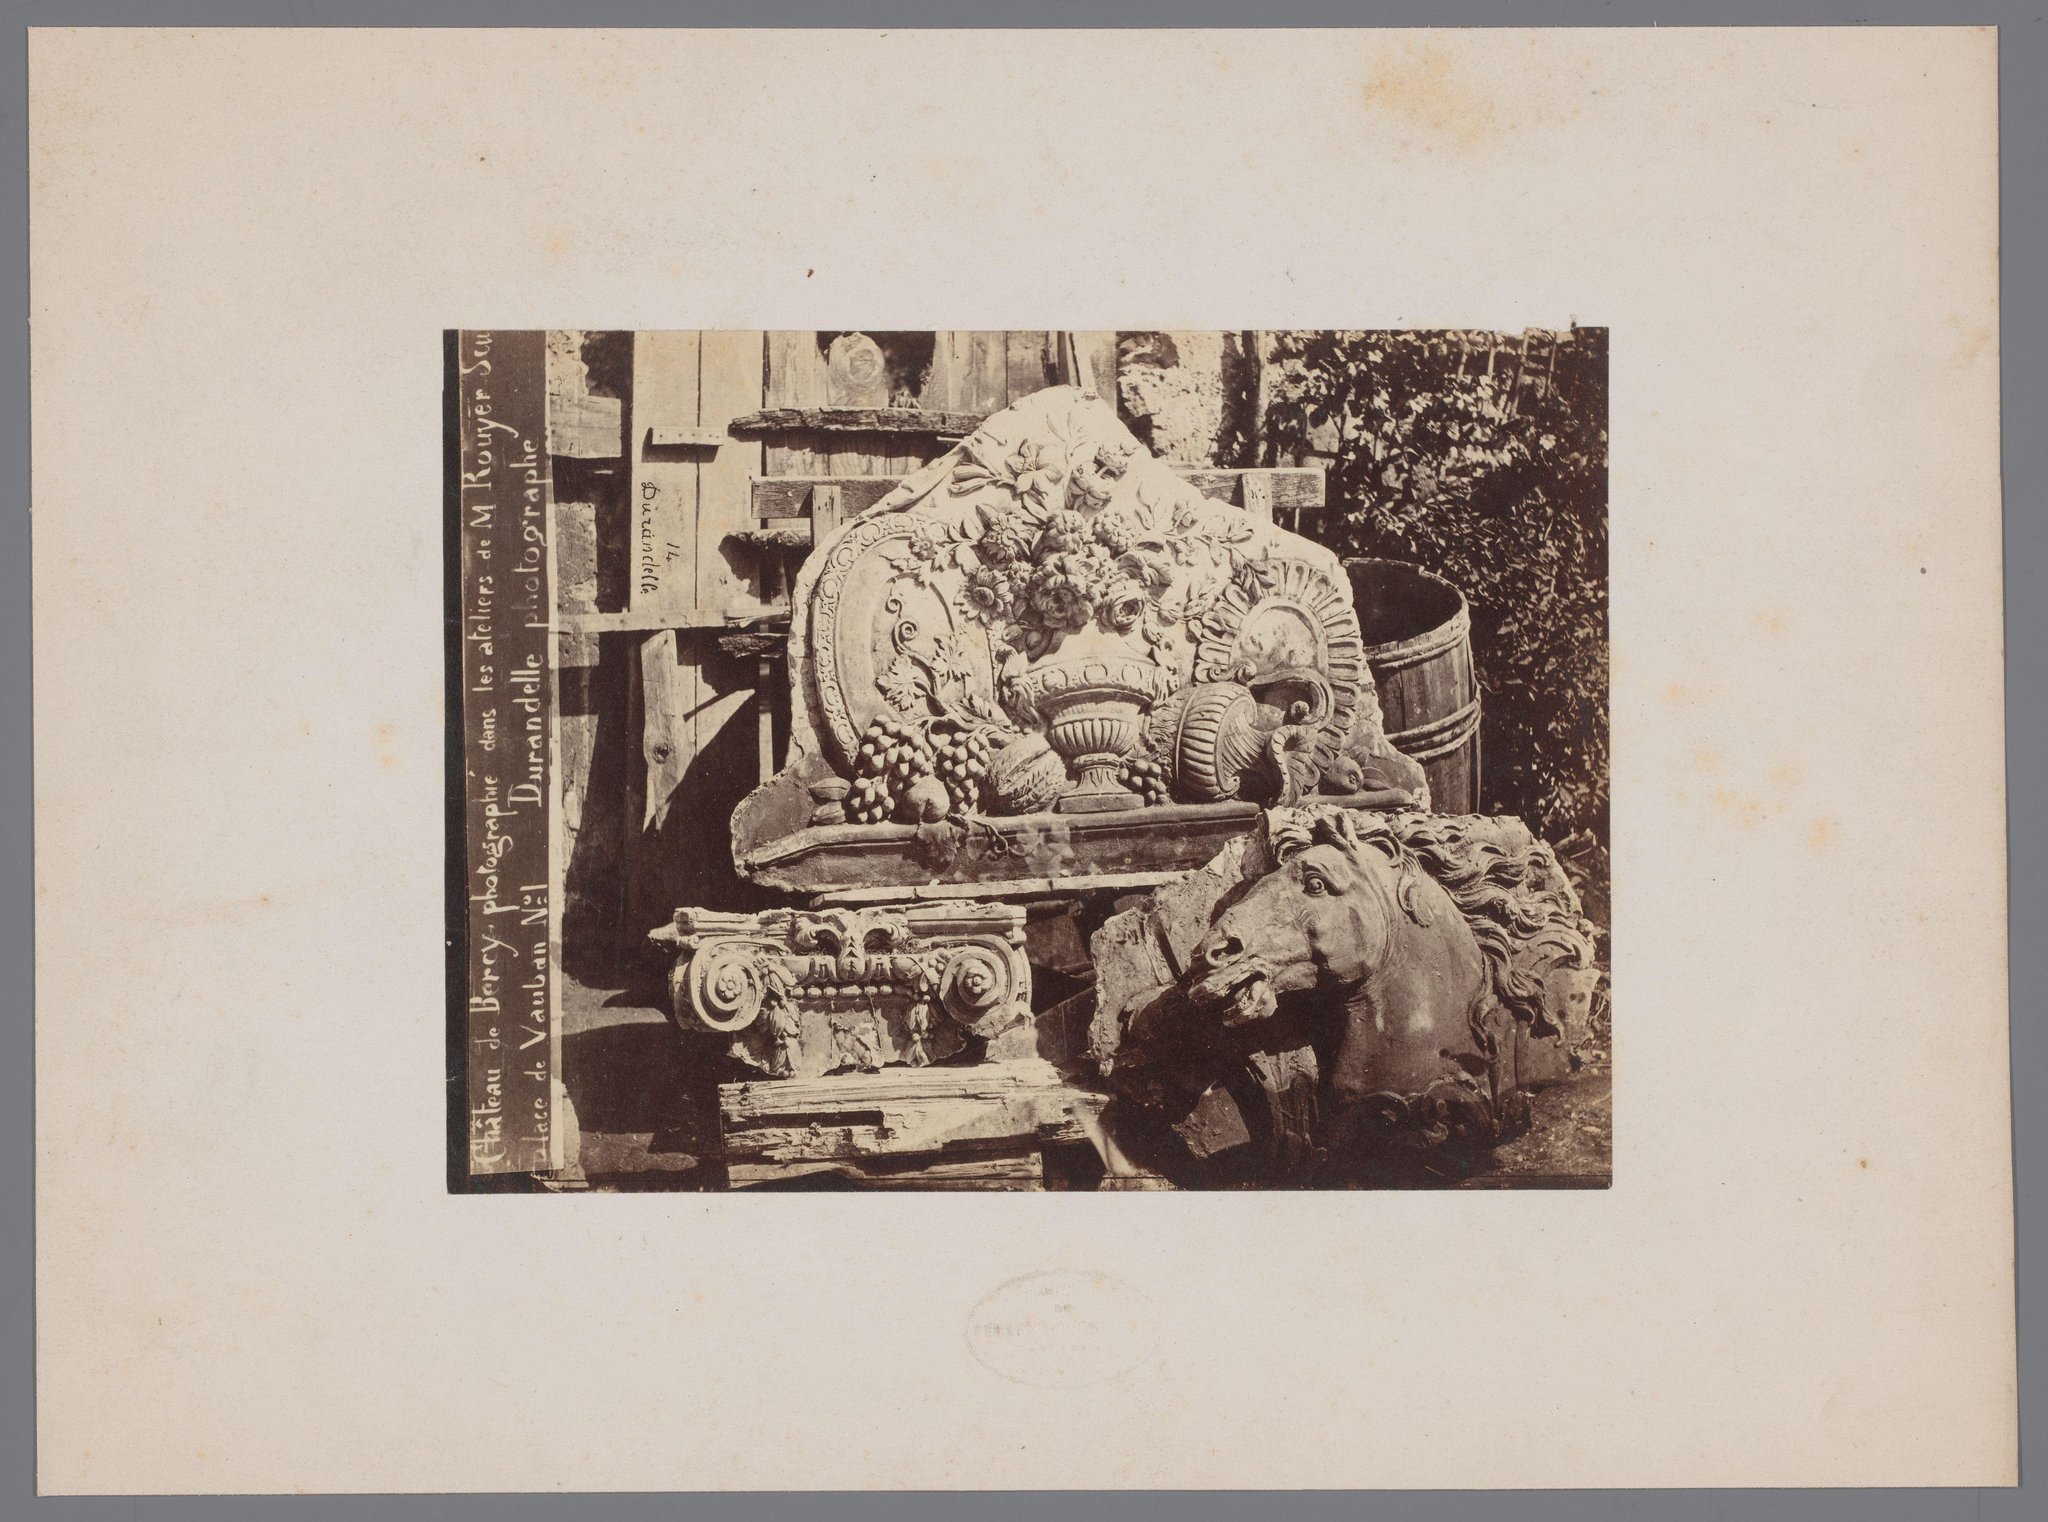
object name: photograph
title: Bouwfragmenten van Chateau de Bercy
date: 1870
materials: cardboard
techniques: albumen print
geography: france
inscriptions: check stamp: ‘Durandelle & Delmaet’, inscription: ‘Château de Bercy photographié dans les ateliers de M. Rouyer [..] place de Vauban No. 1 Durandelle photographe’, signature: ‘14 Durandelle’